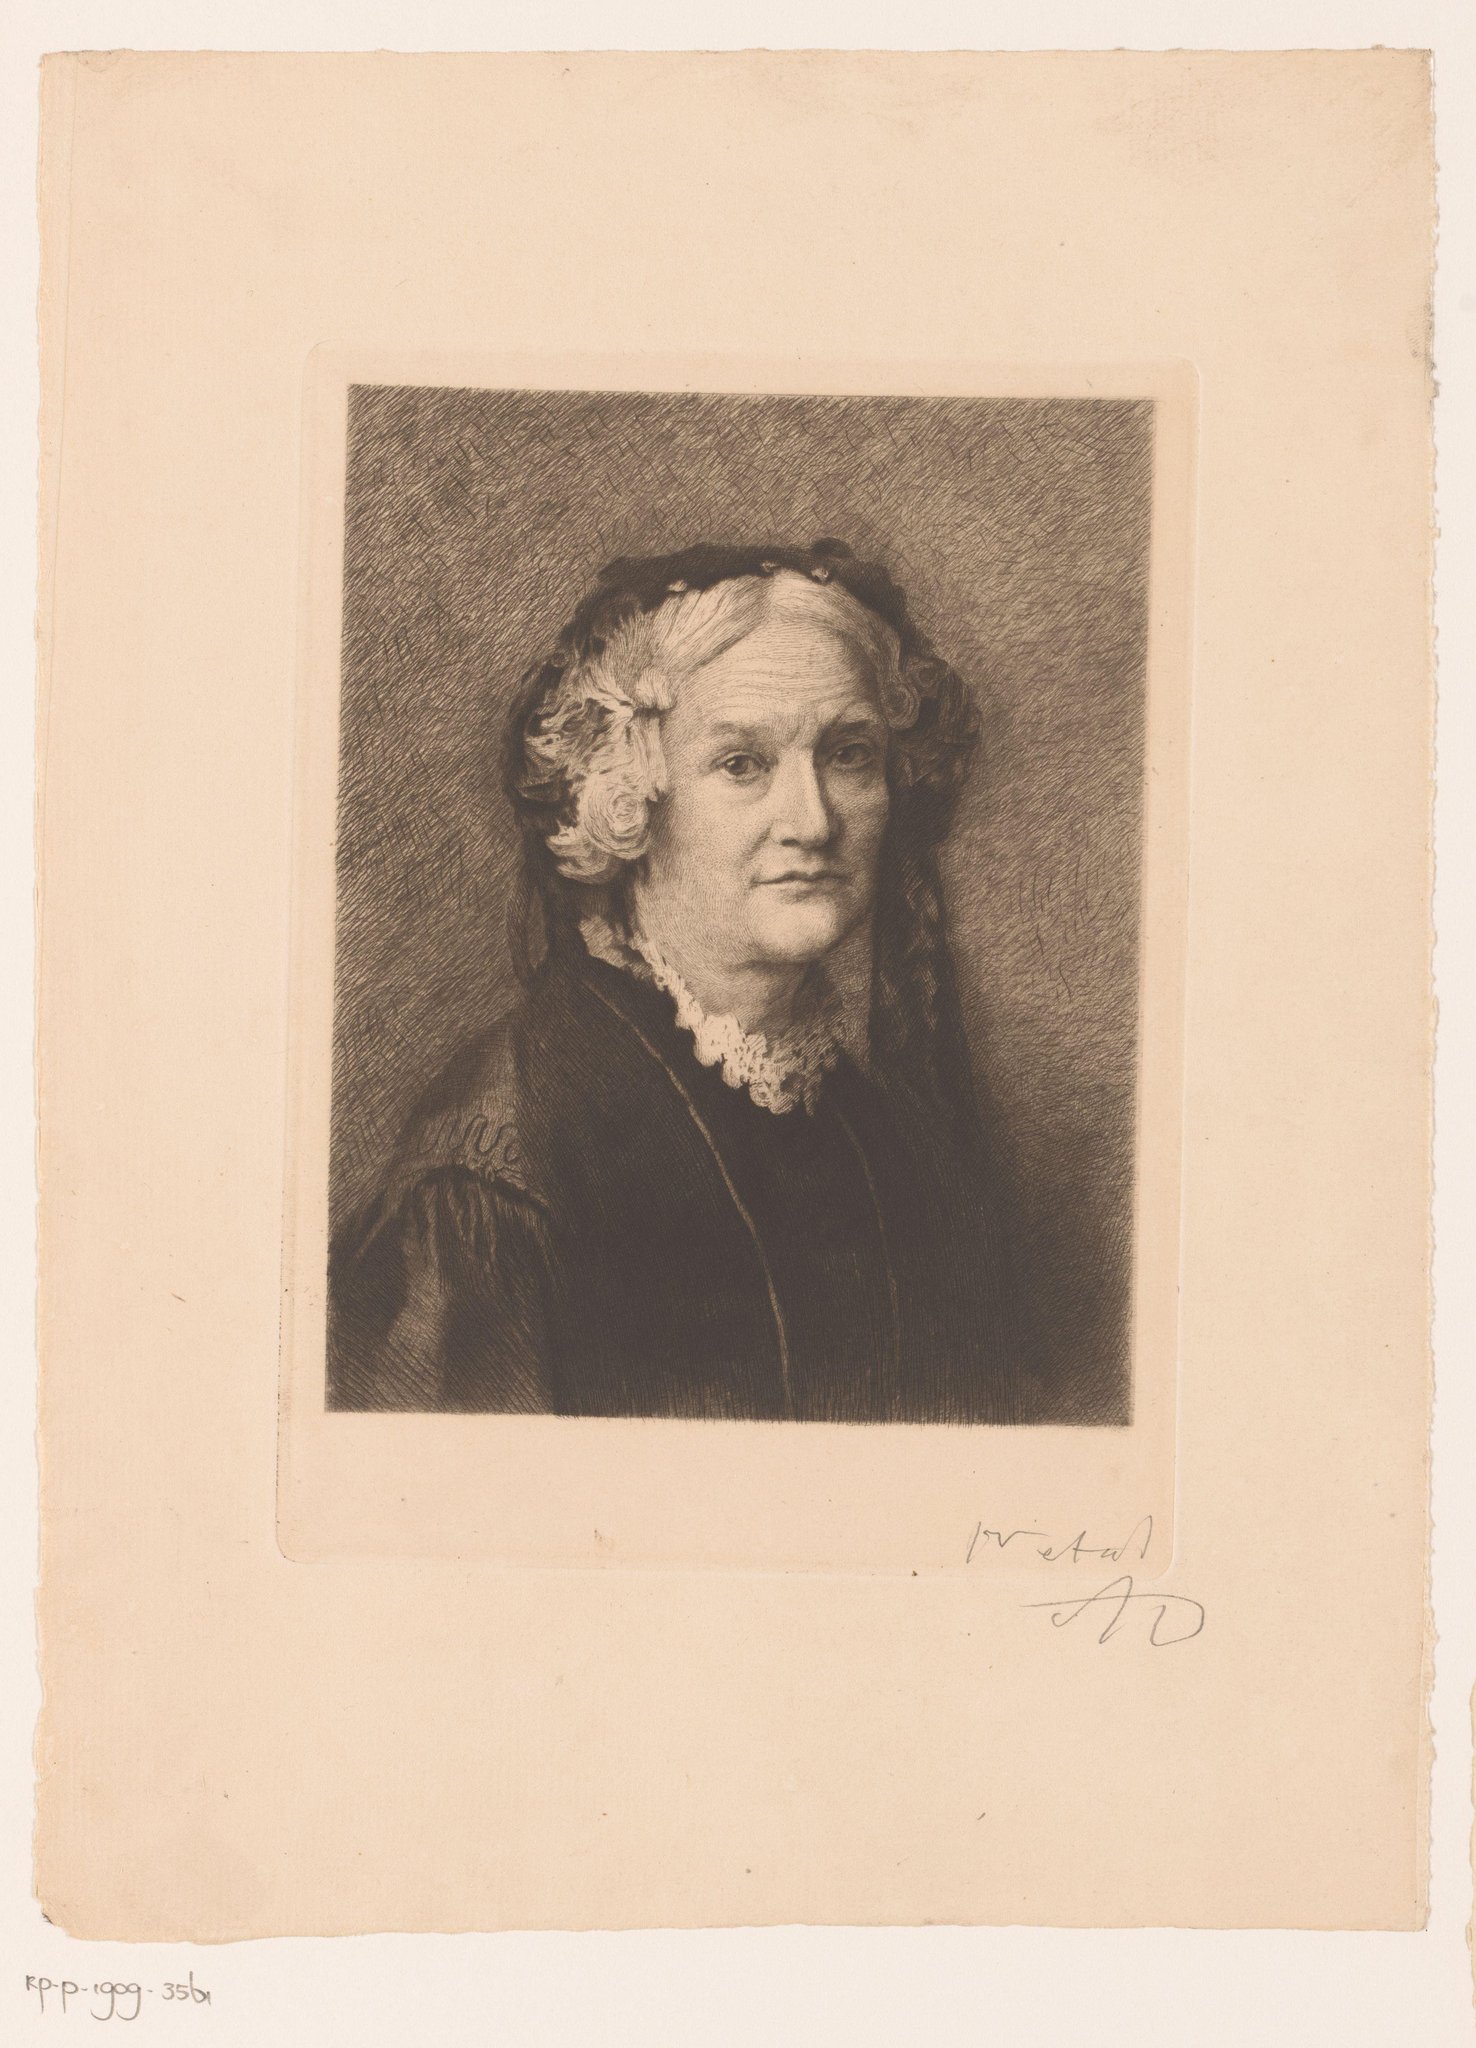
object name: print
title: Portret van een onbekende vrouw, madame Huberti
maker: auguste danse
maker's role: print maker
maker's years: 1829-1929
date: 1895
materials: paper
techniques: drypoint, etching, intaglio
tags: anonymous historical person portrayed alone - bb - woman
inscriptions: annotation: ‘1er état’, collector's mark: Lugt 2228